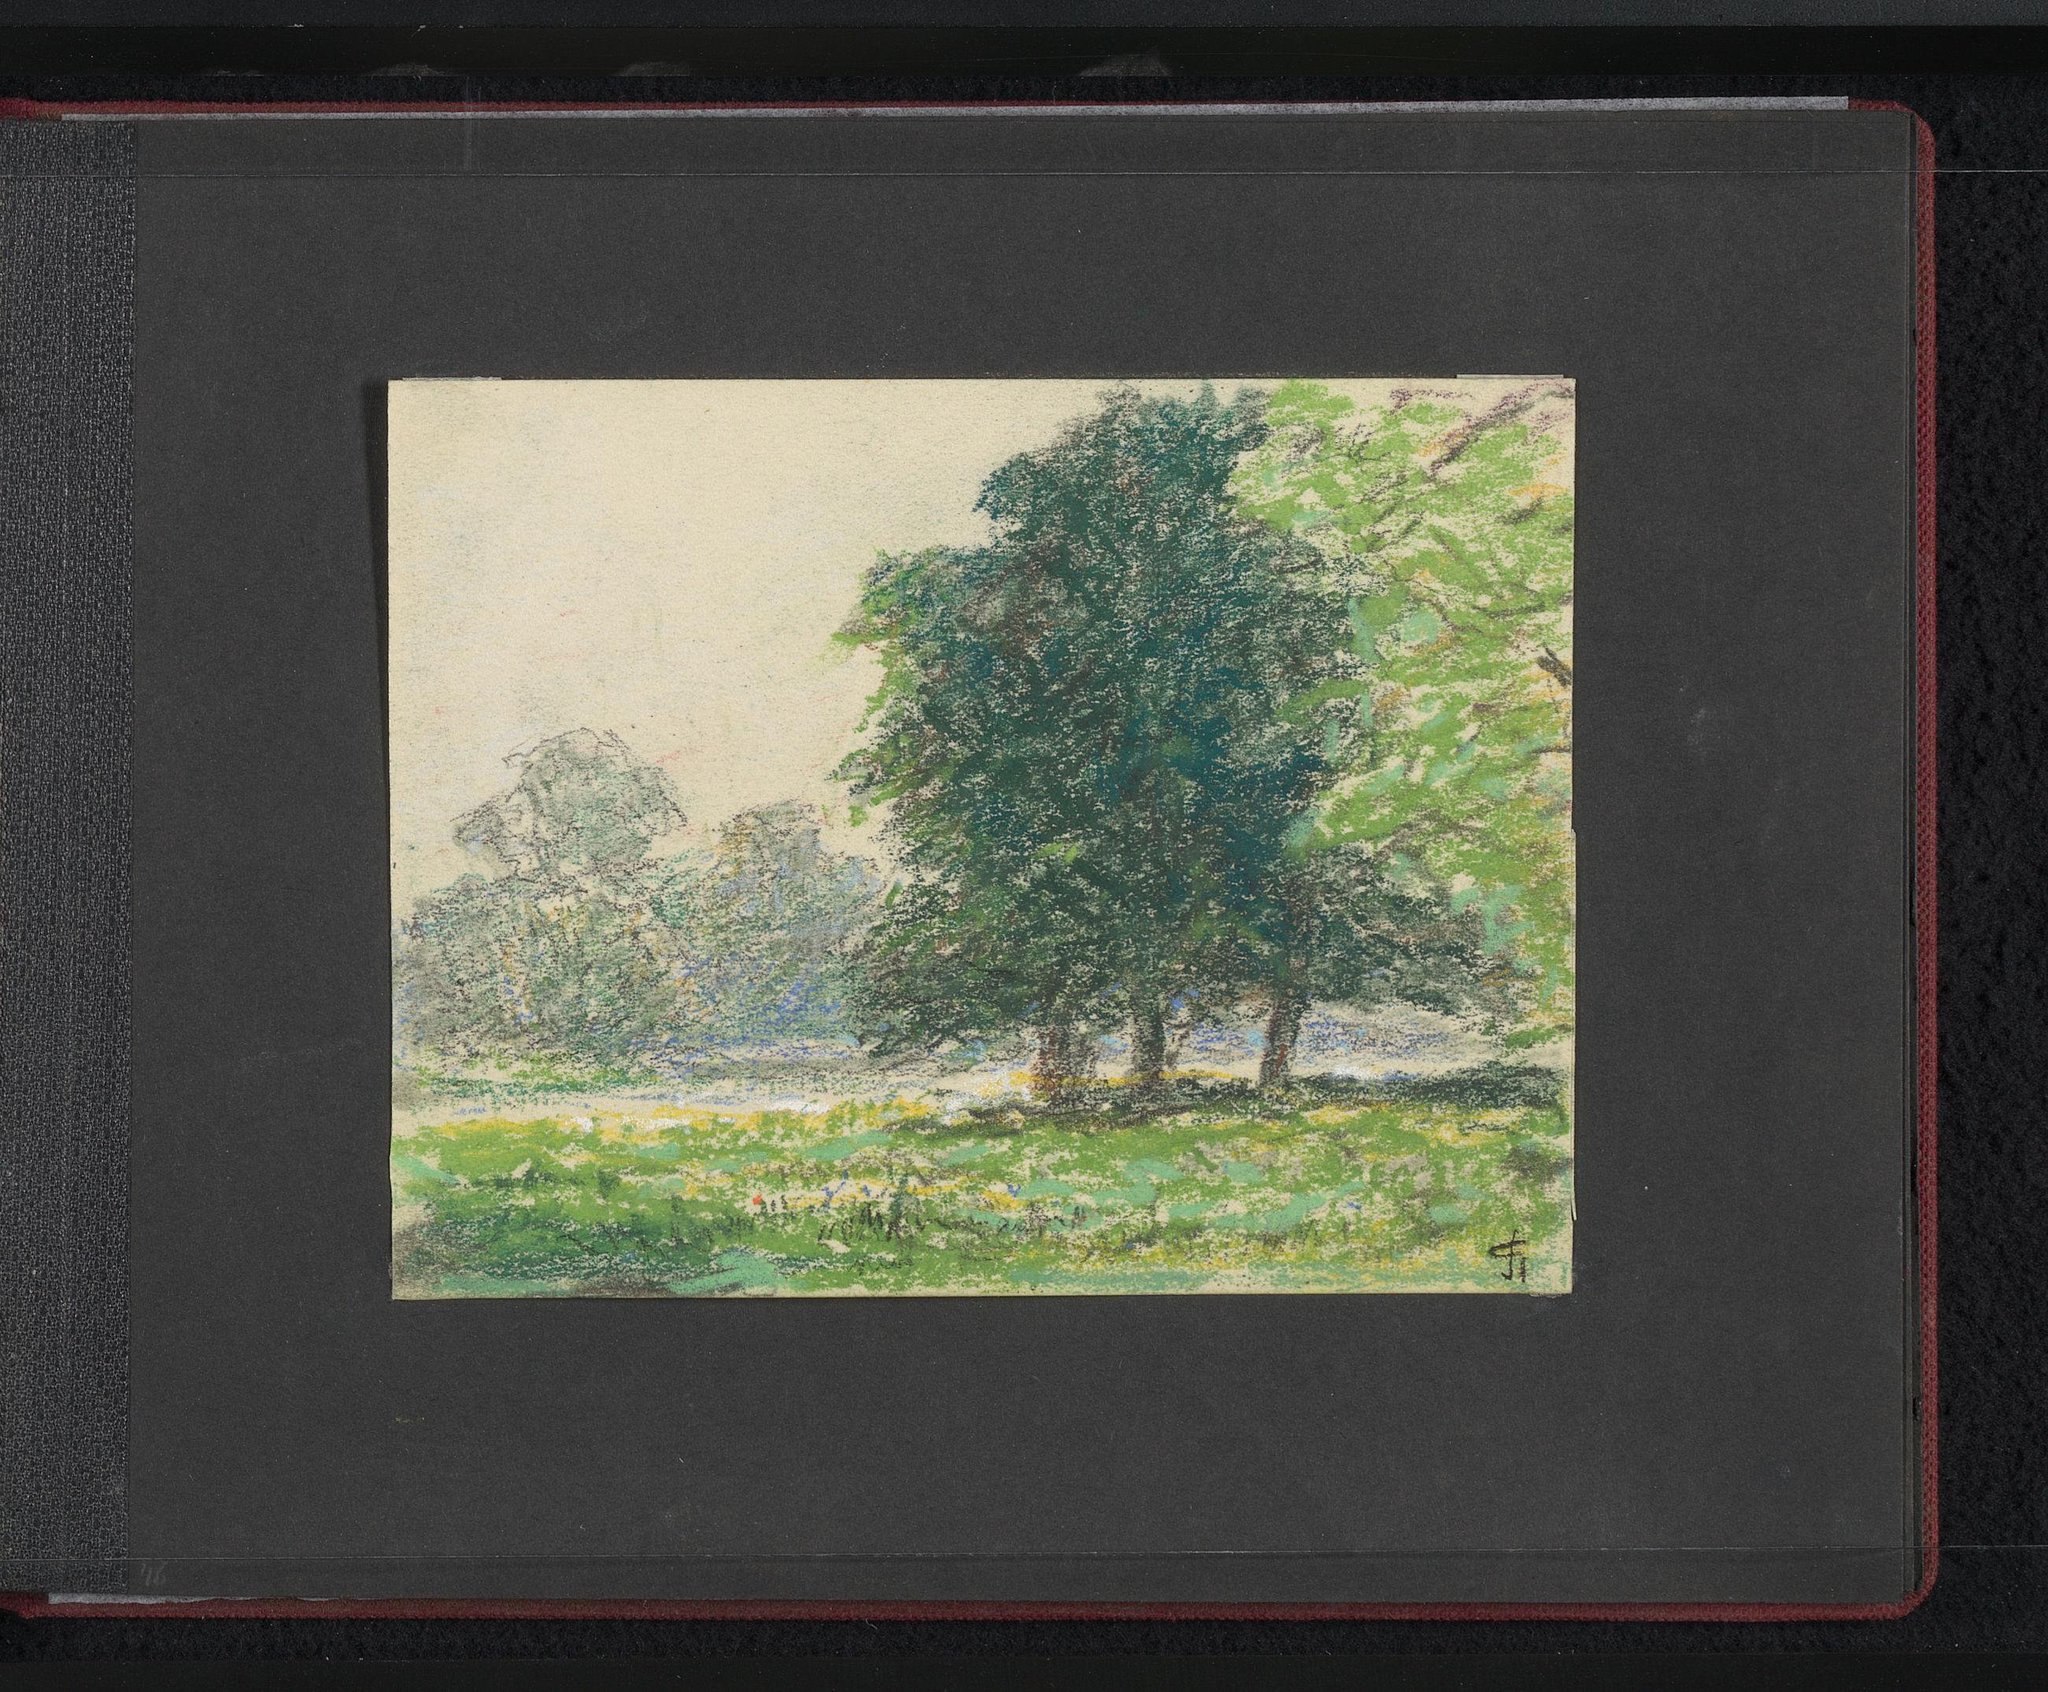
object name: album leaf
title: Park met bomen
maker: carel nicolaas storm van s-gravesande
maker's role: draughtsman, print maker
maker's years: 1841-1924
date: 1915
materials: chalk, paper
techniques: pasting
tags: park, trees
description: Mogelijk in het park van Slot Biebrich te Wiesbaden. Tekening maakt deel uit van een album.